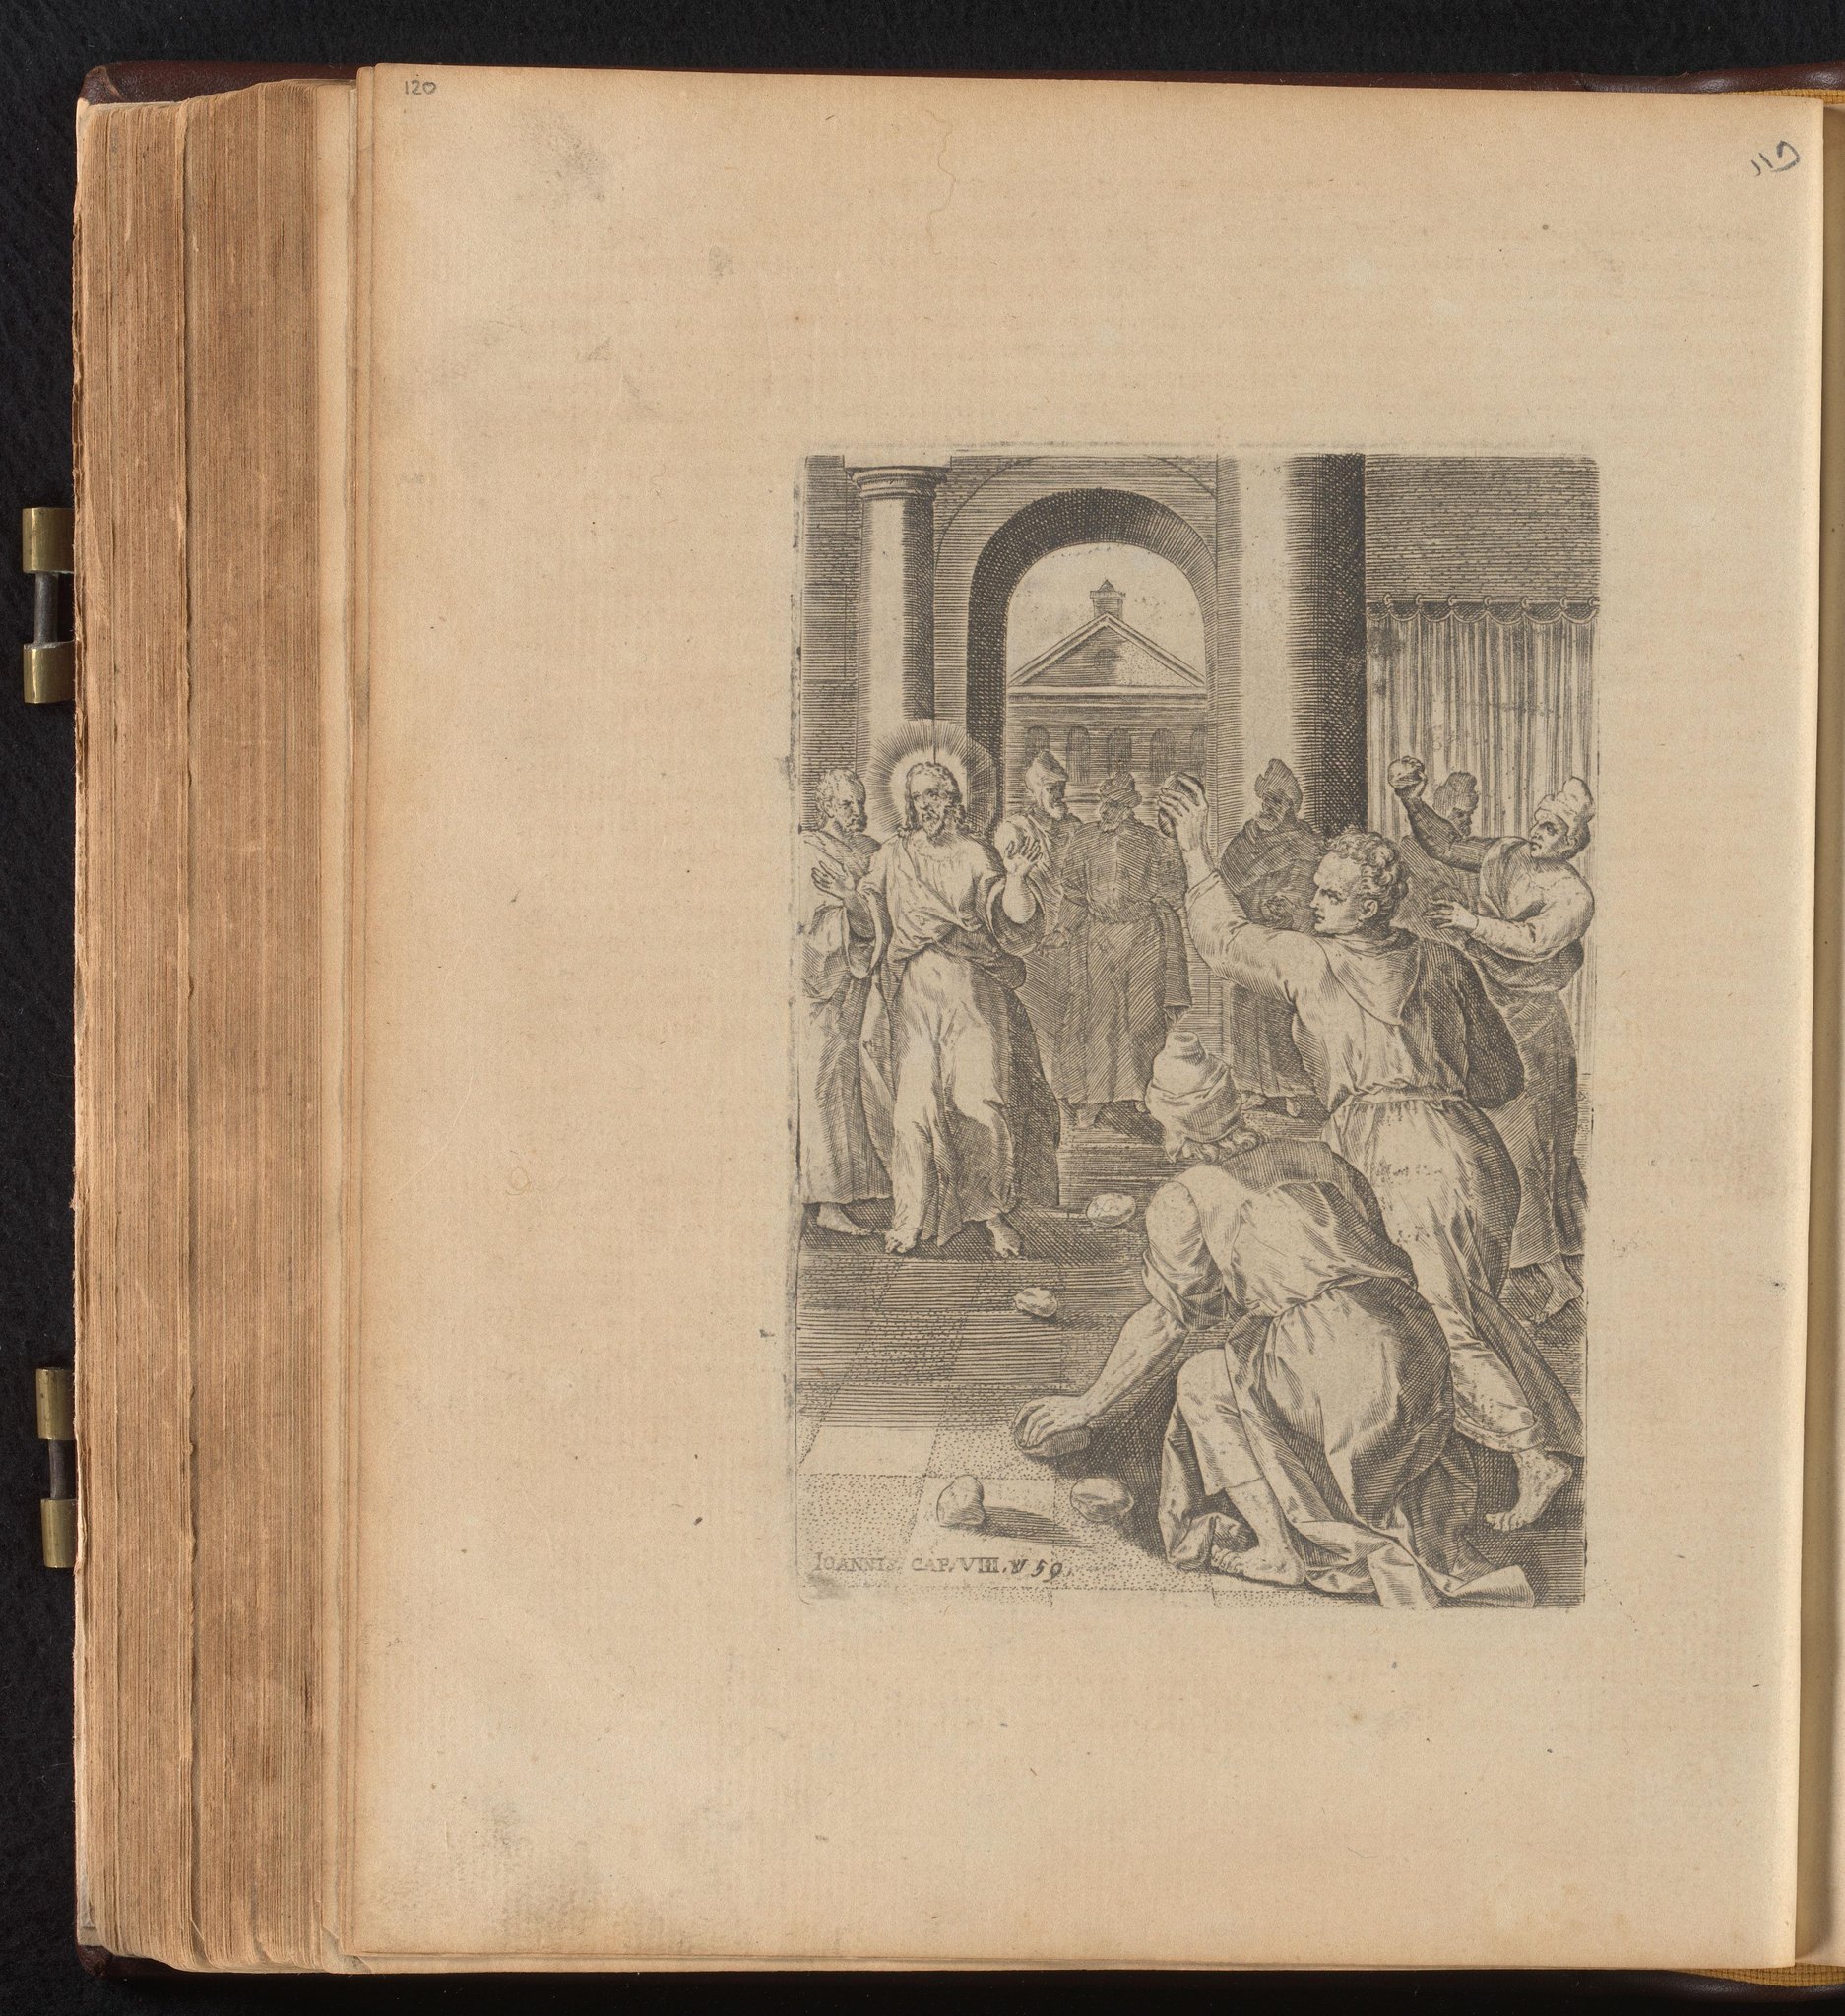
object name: album leaf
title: Joden in de tempel gooien stenen naar Christus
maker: Anonymous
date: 1583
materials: paper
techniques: engraving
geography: southern netherlands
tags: attempts to stone christ (john 8:59, 10:31-33)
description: Eerdere staat van prent gebruikt als boekillustratie in: Biblia Sacra. Antwerpen: Christoffel Plantijn, 1583.